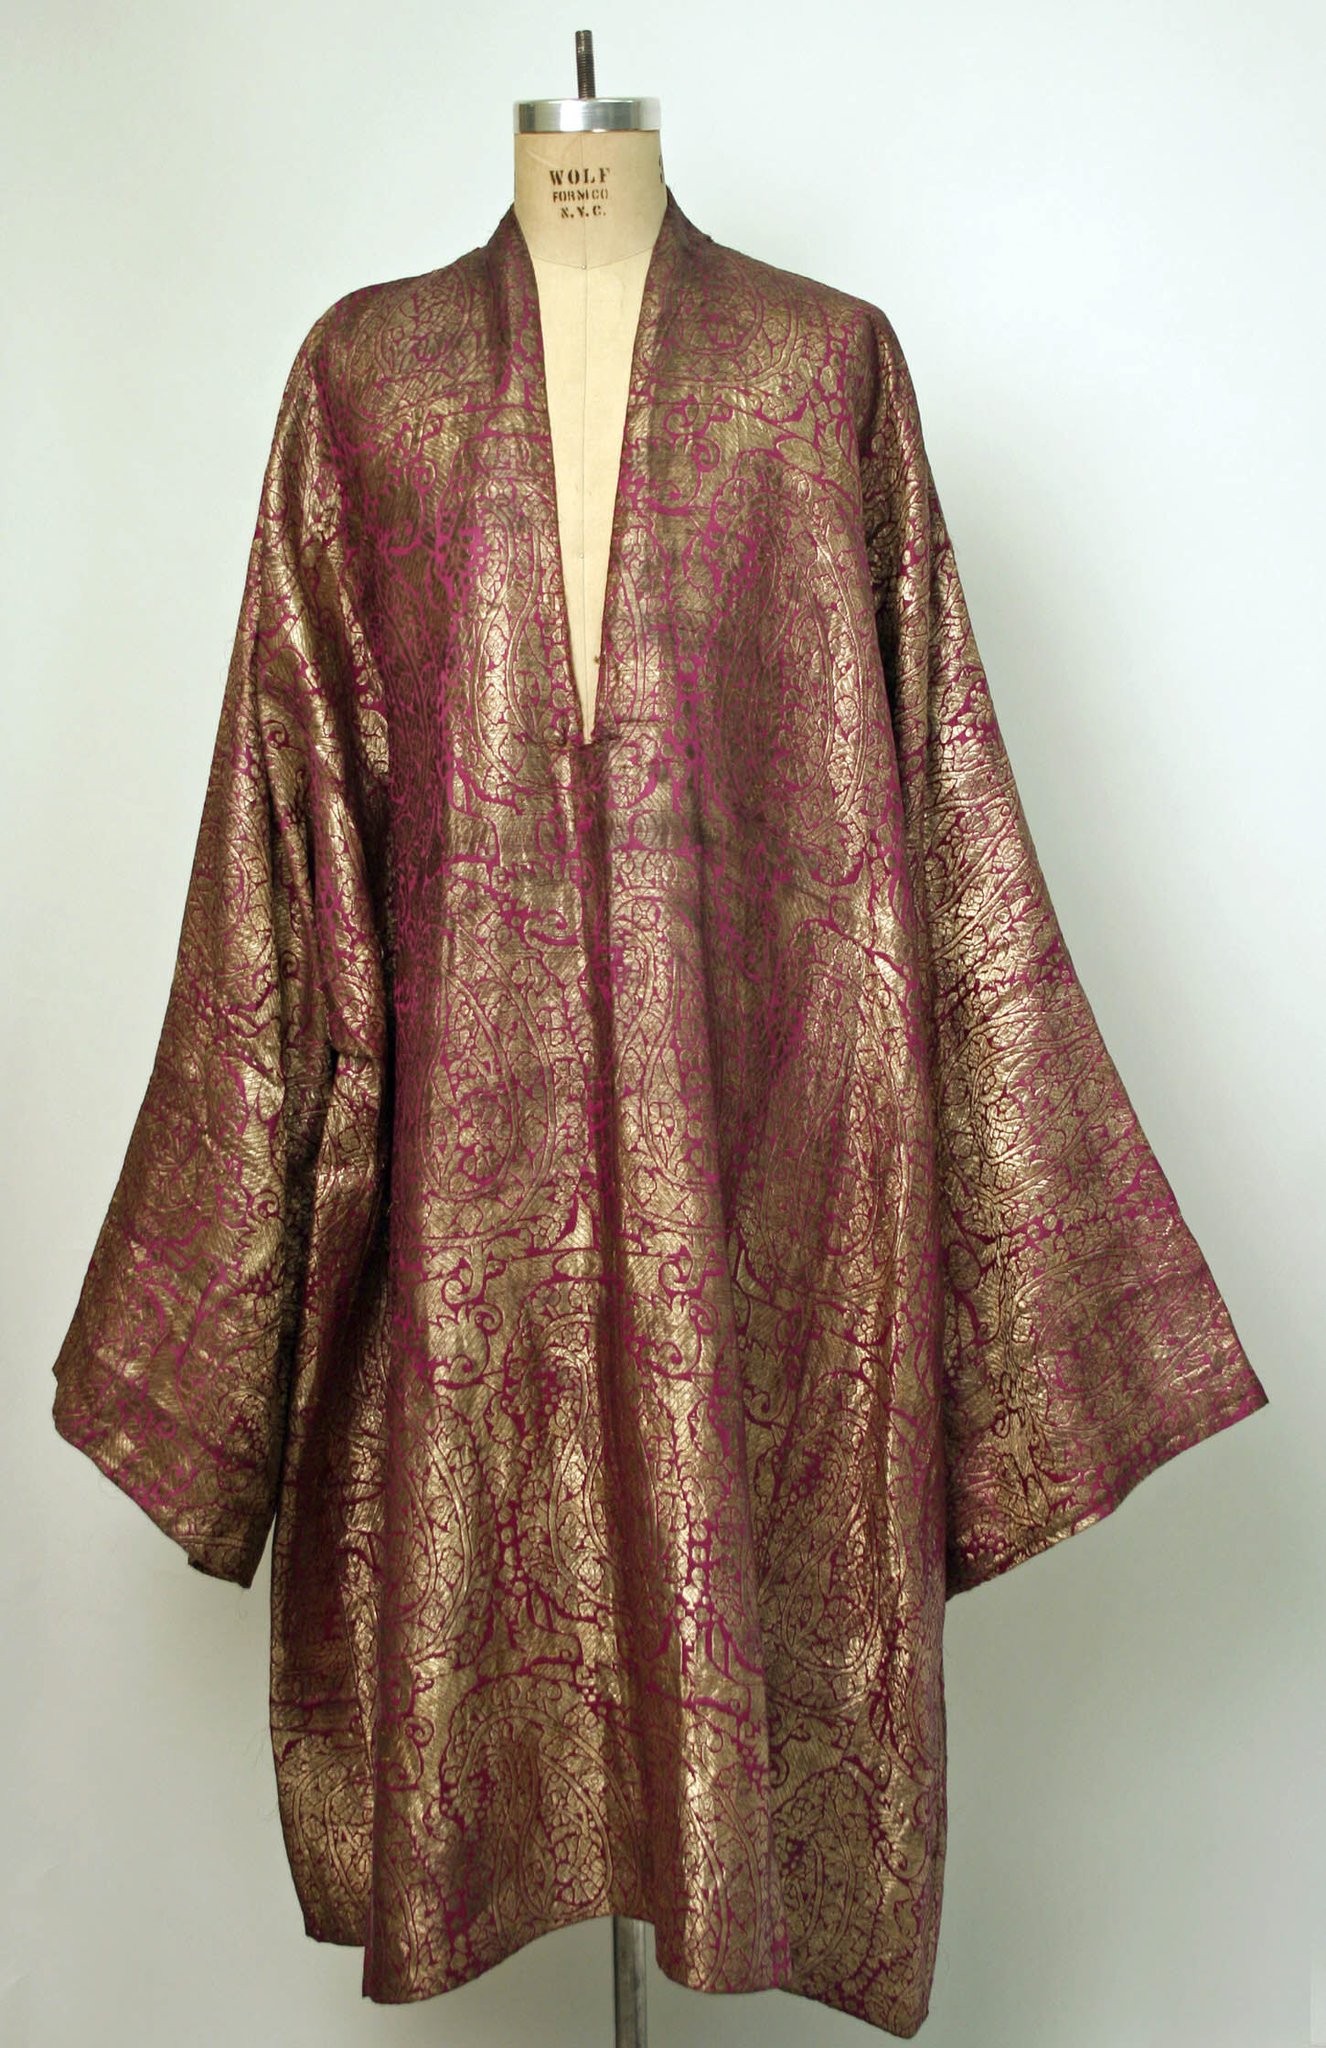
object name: robe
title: Choga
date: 1867-1900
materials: metal thread, silk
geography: india